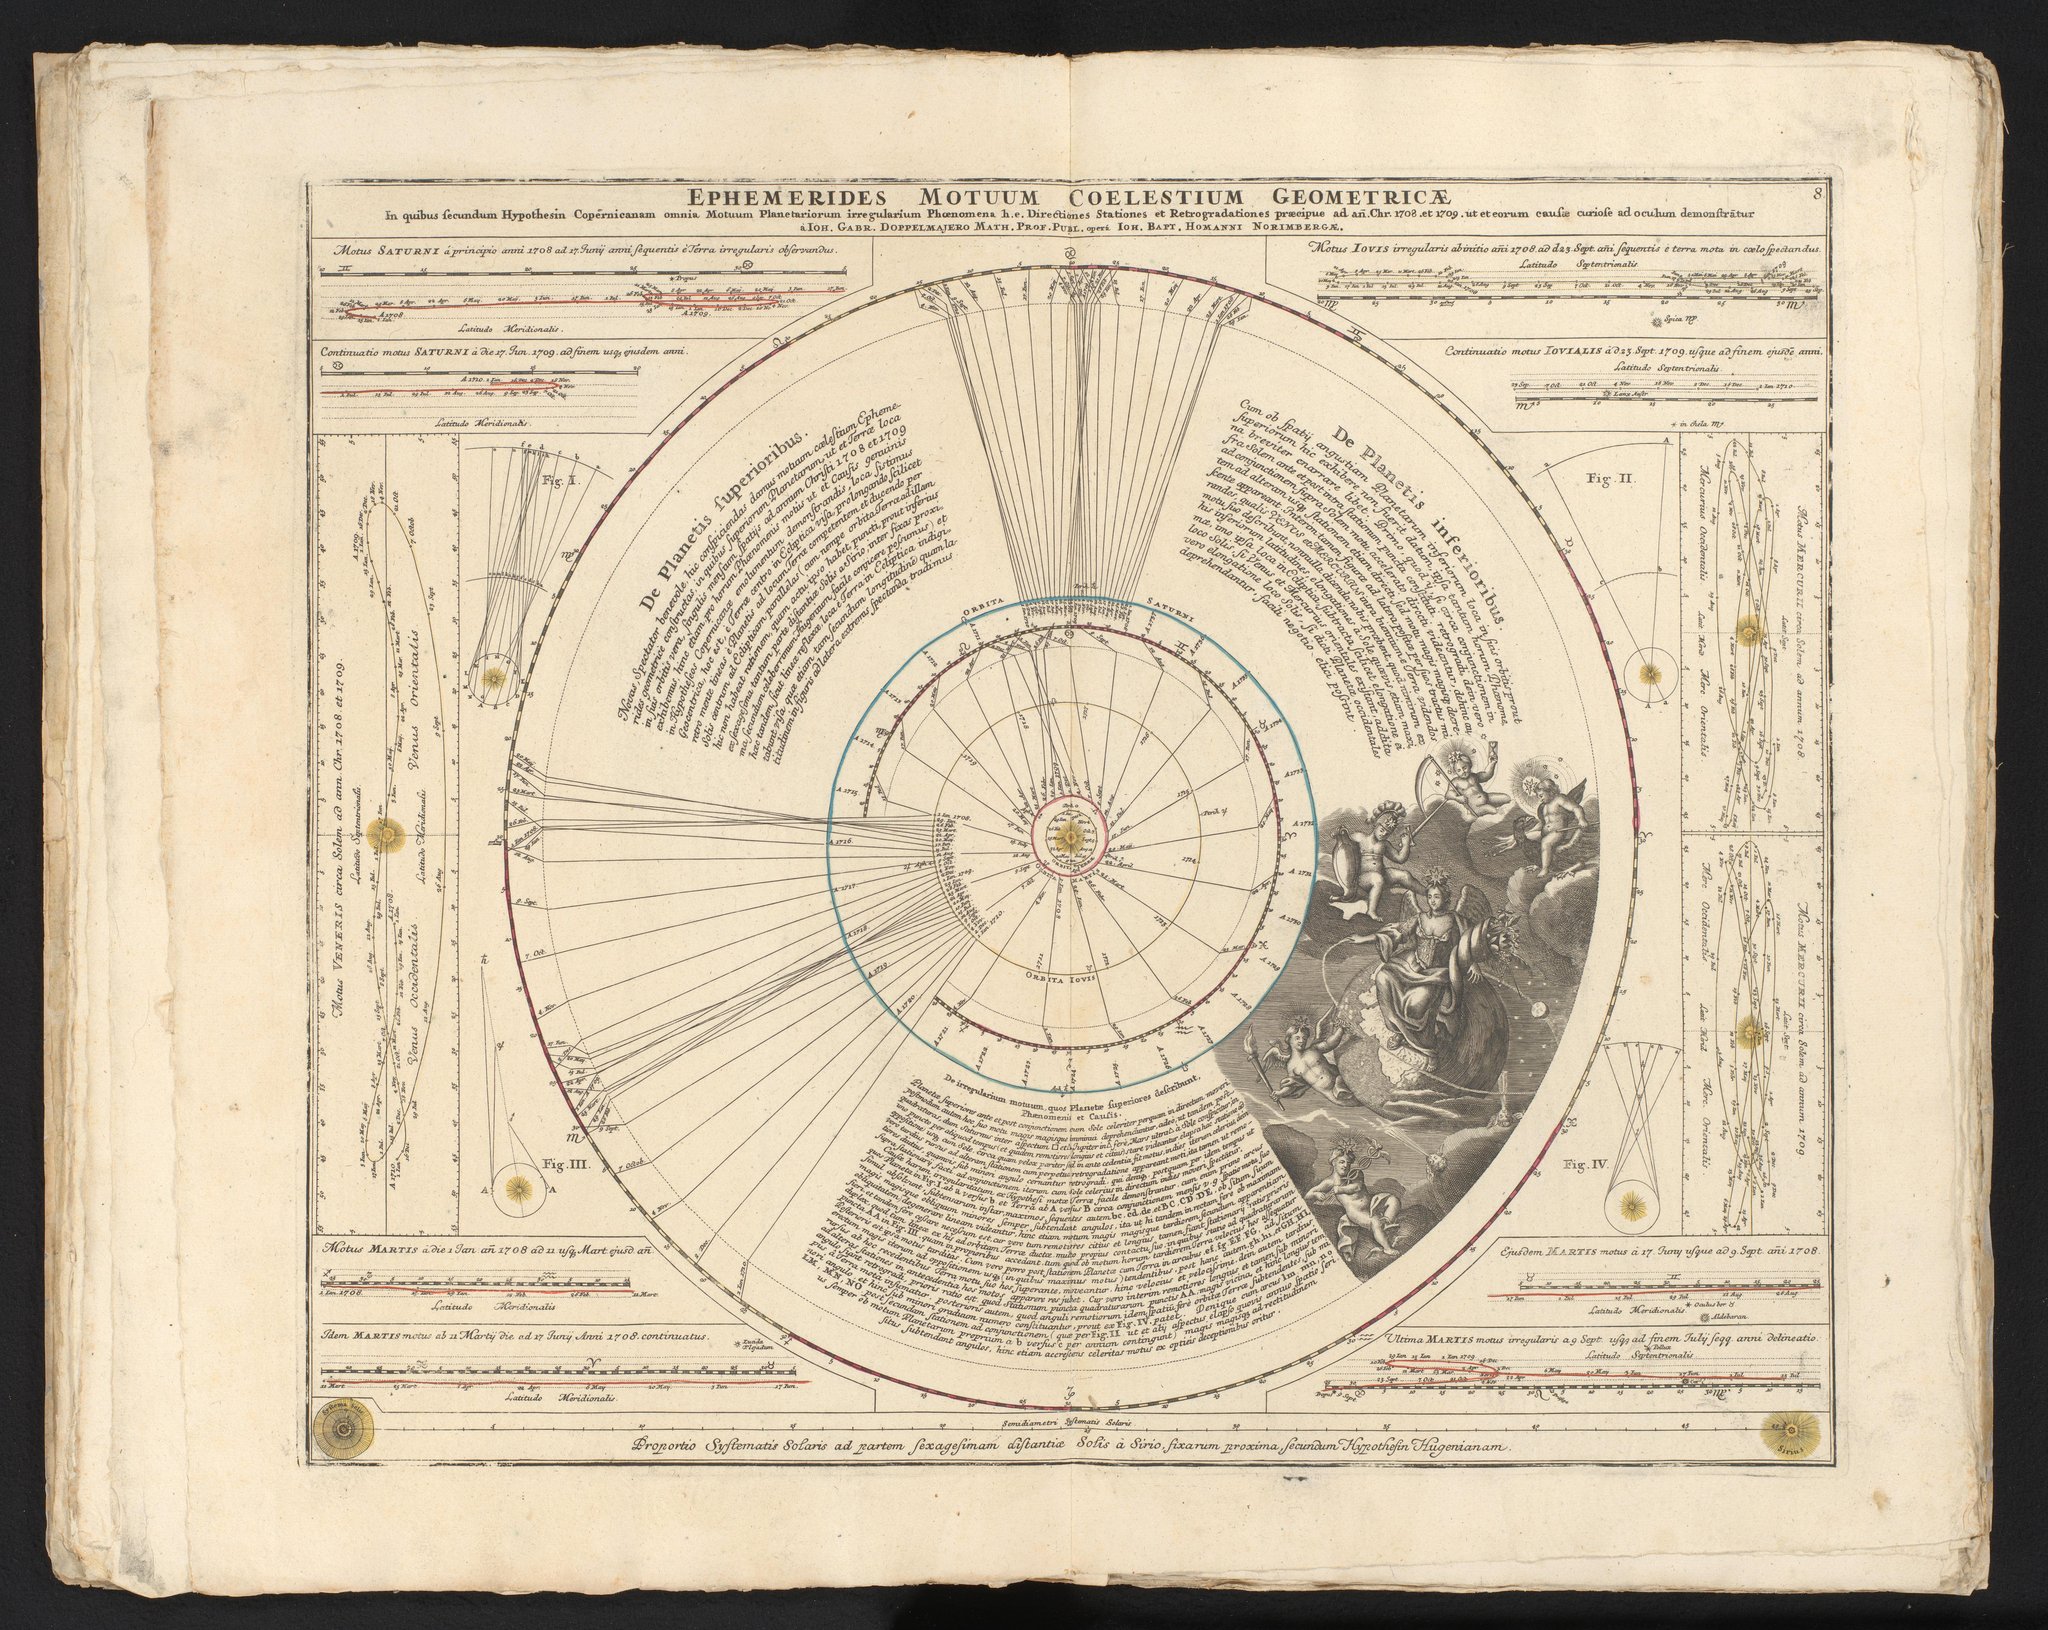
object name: print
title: Ephemerides motuum coelestium geometricae in quibus secundum (...)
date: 1742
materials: paper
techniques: engraving, etching, hand coloring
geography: nuremberg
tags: star-chart, star map, planets; planetary system, solar system